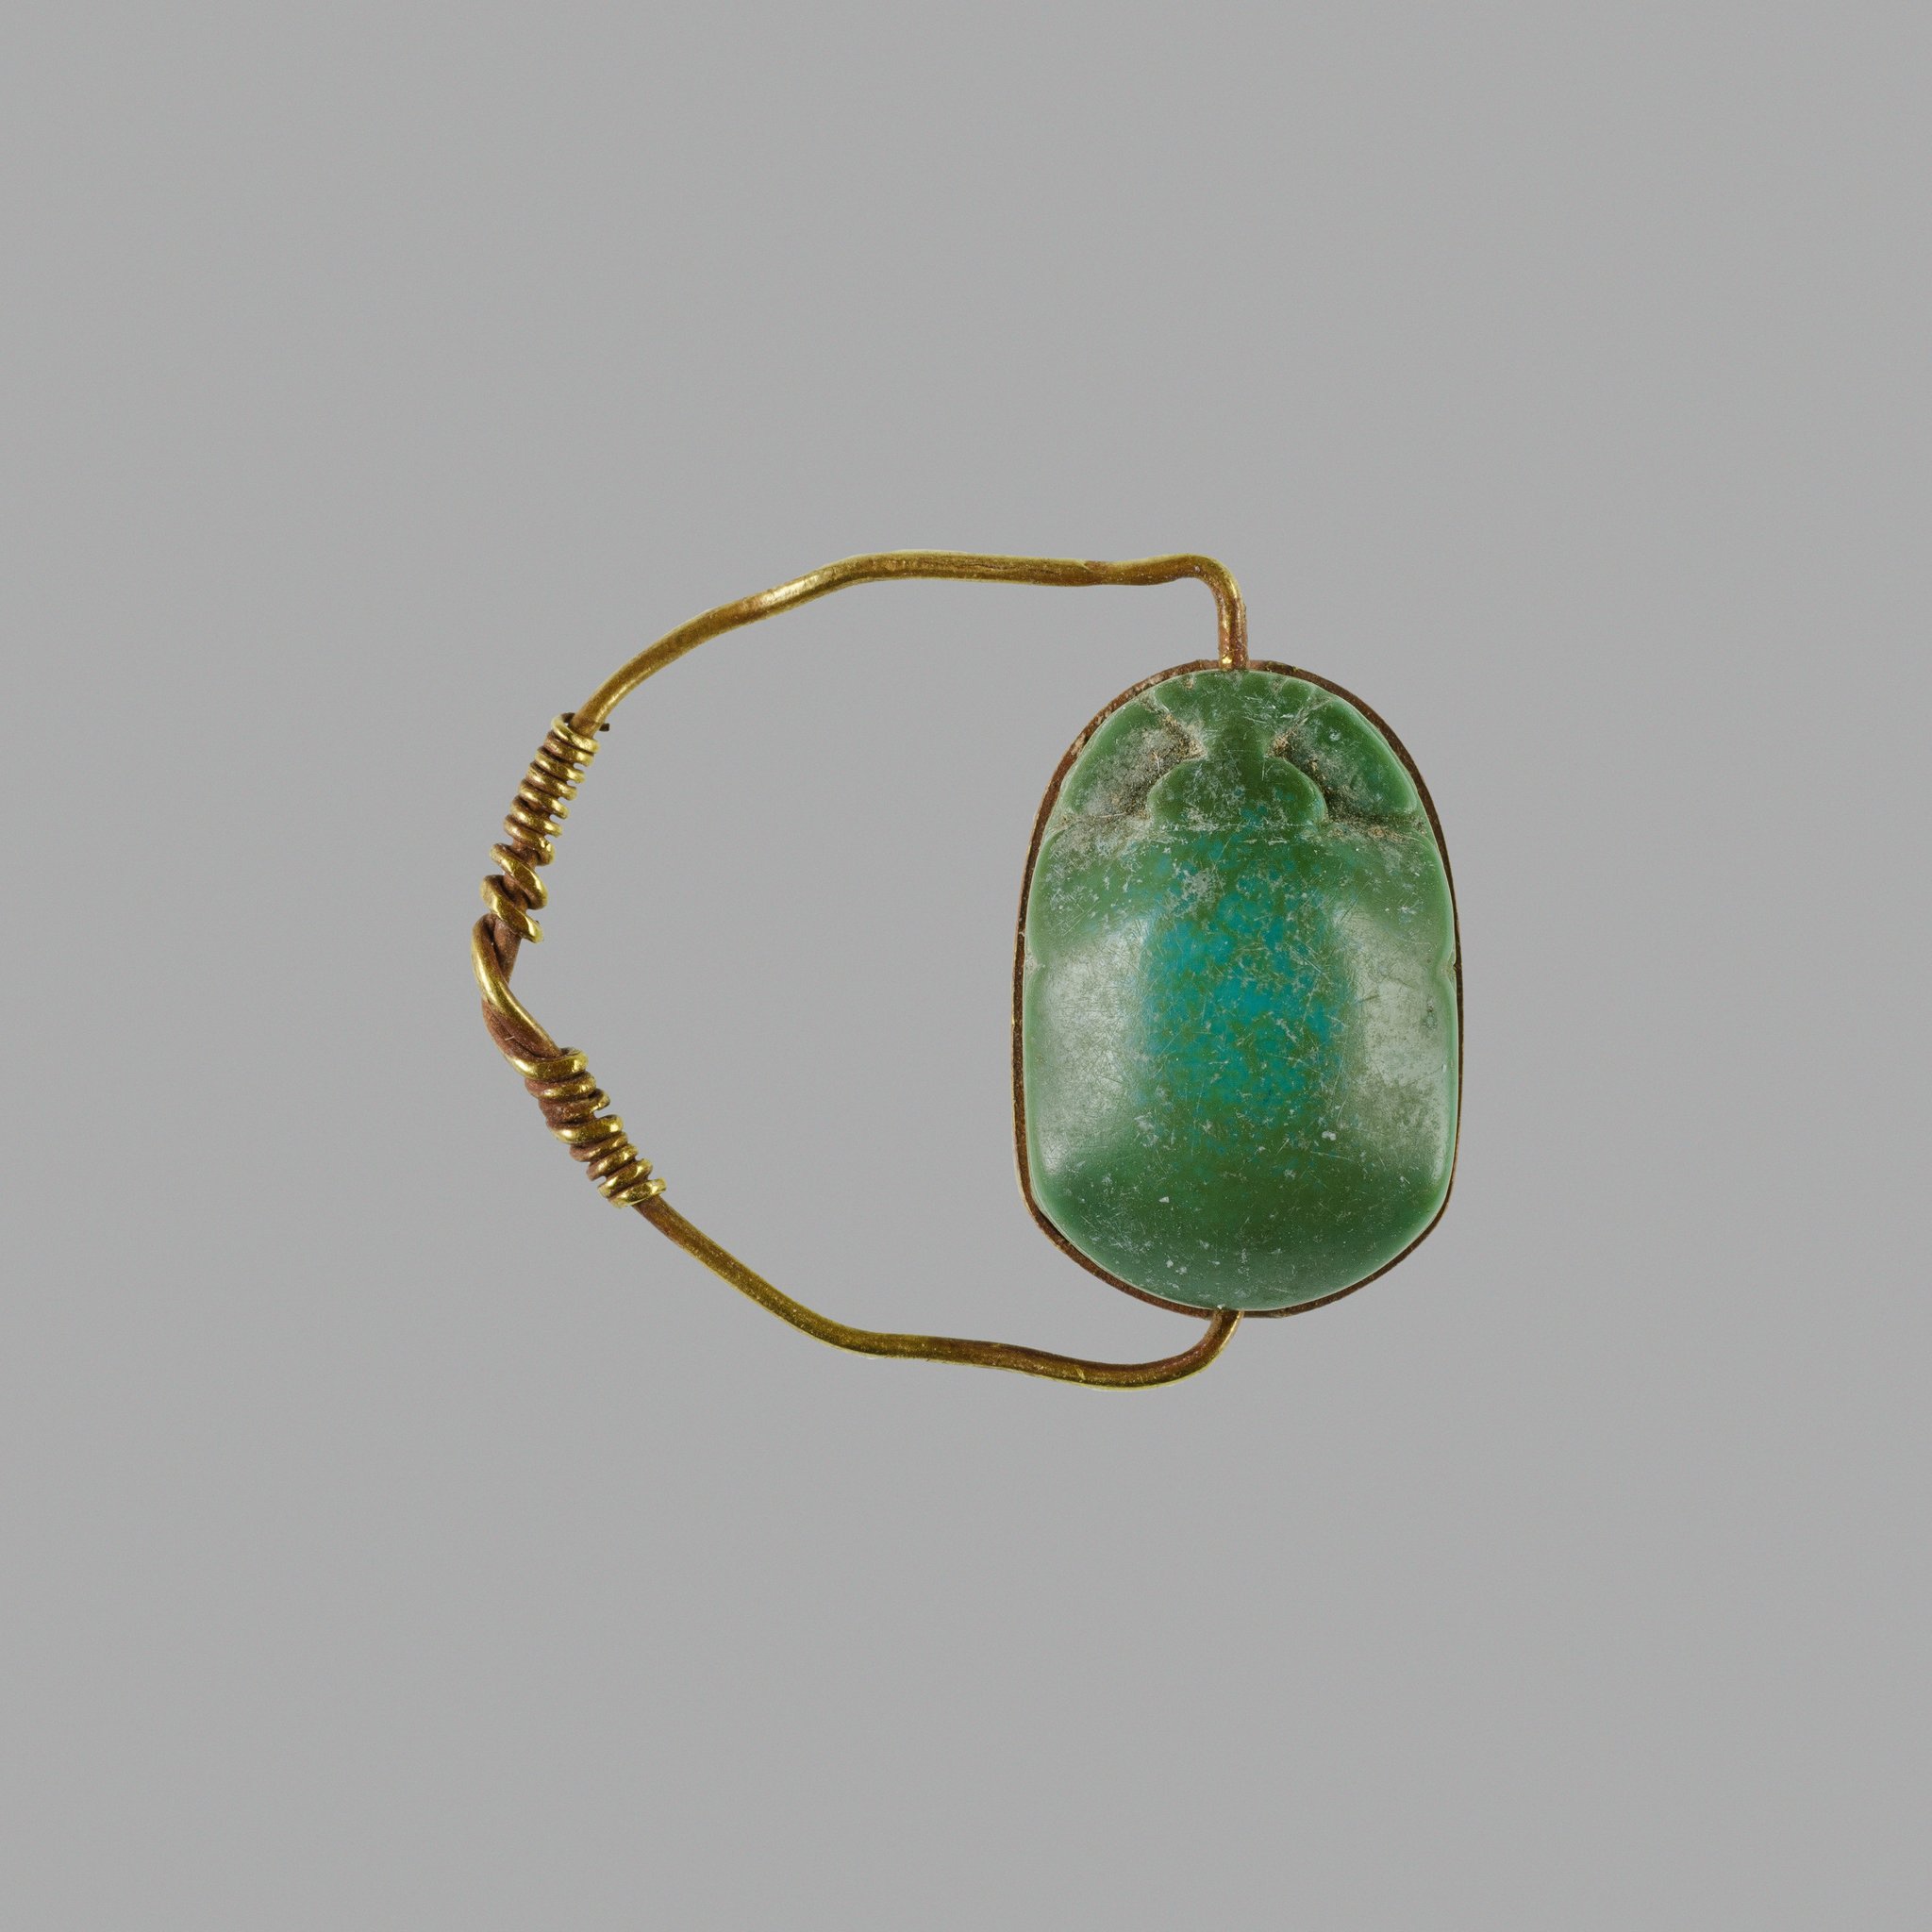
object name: ring with scarab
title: Scarab Finger Ring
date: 1850-1640 BCE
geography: egypt